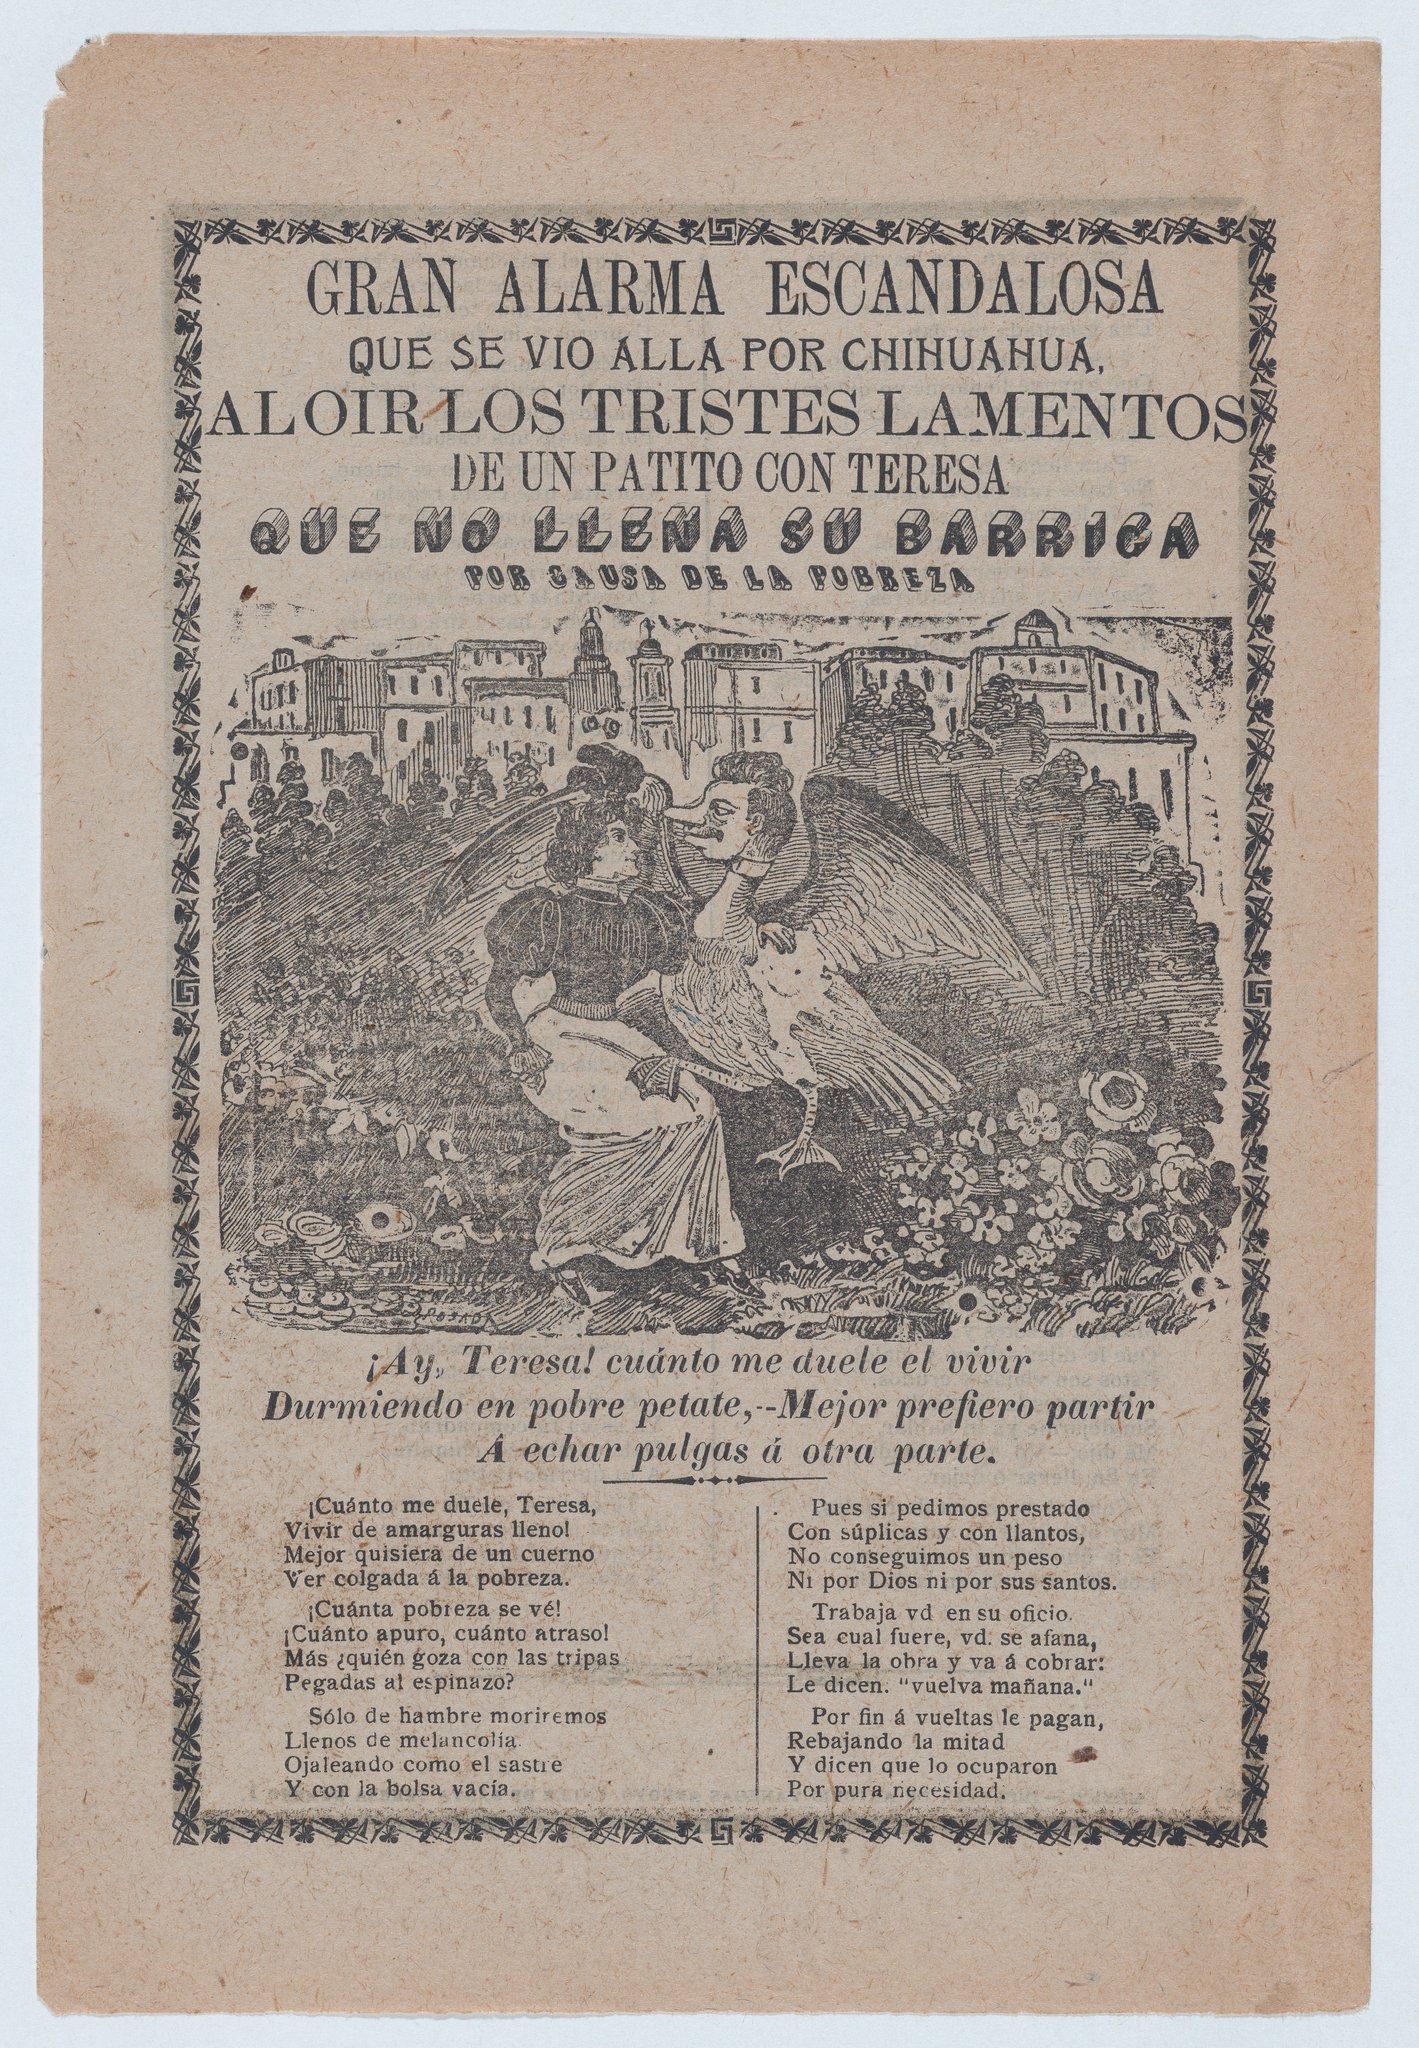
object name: print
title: Broadsheet with a ballad addressing poverty, woman sitting in a field of flowers with a duck that has a human's head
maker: josé guadalupe posada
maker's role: artist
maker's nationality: mexican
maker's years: 1852-1913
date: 1904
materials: paper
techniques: letterpress, lithography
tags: satire,women